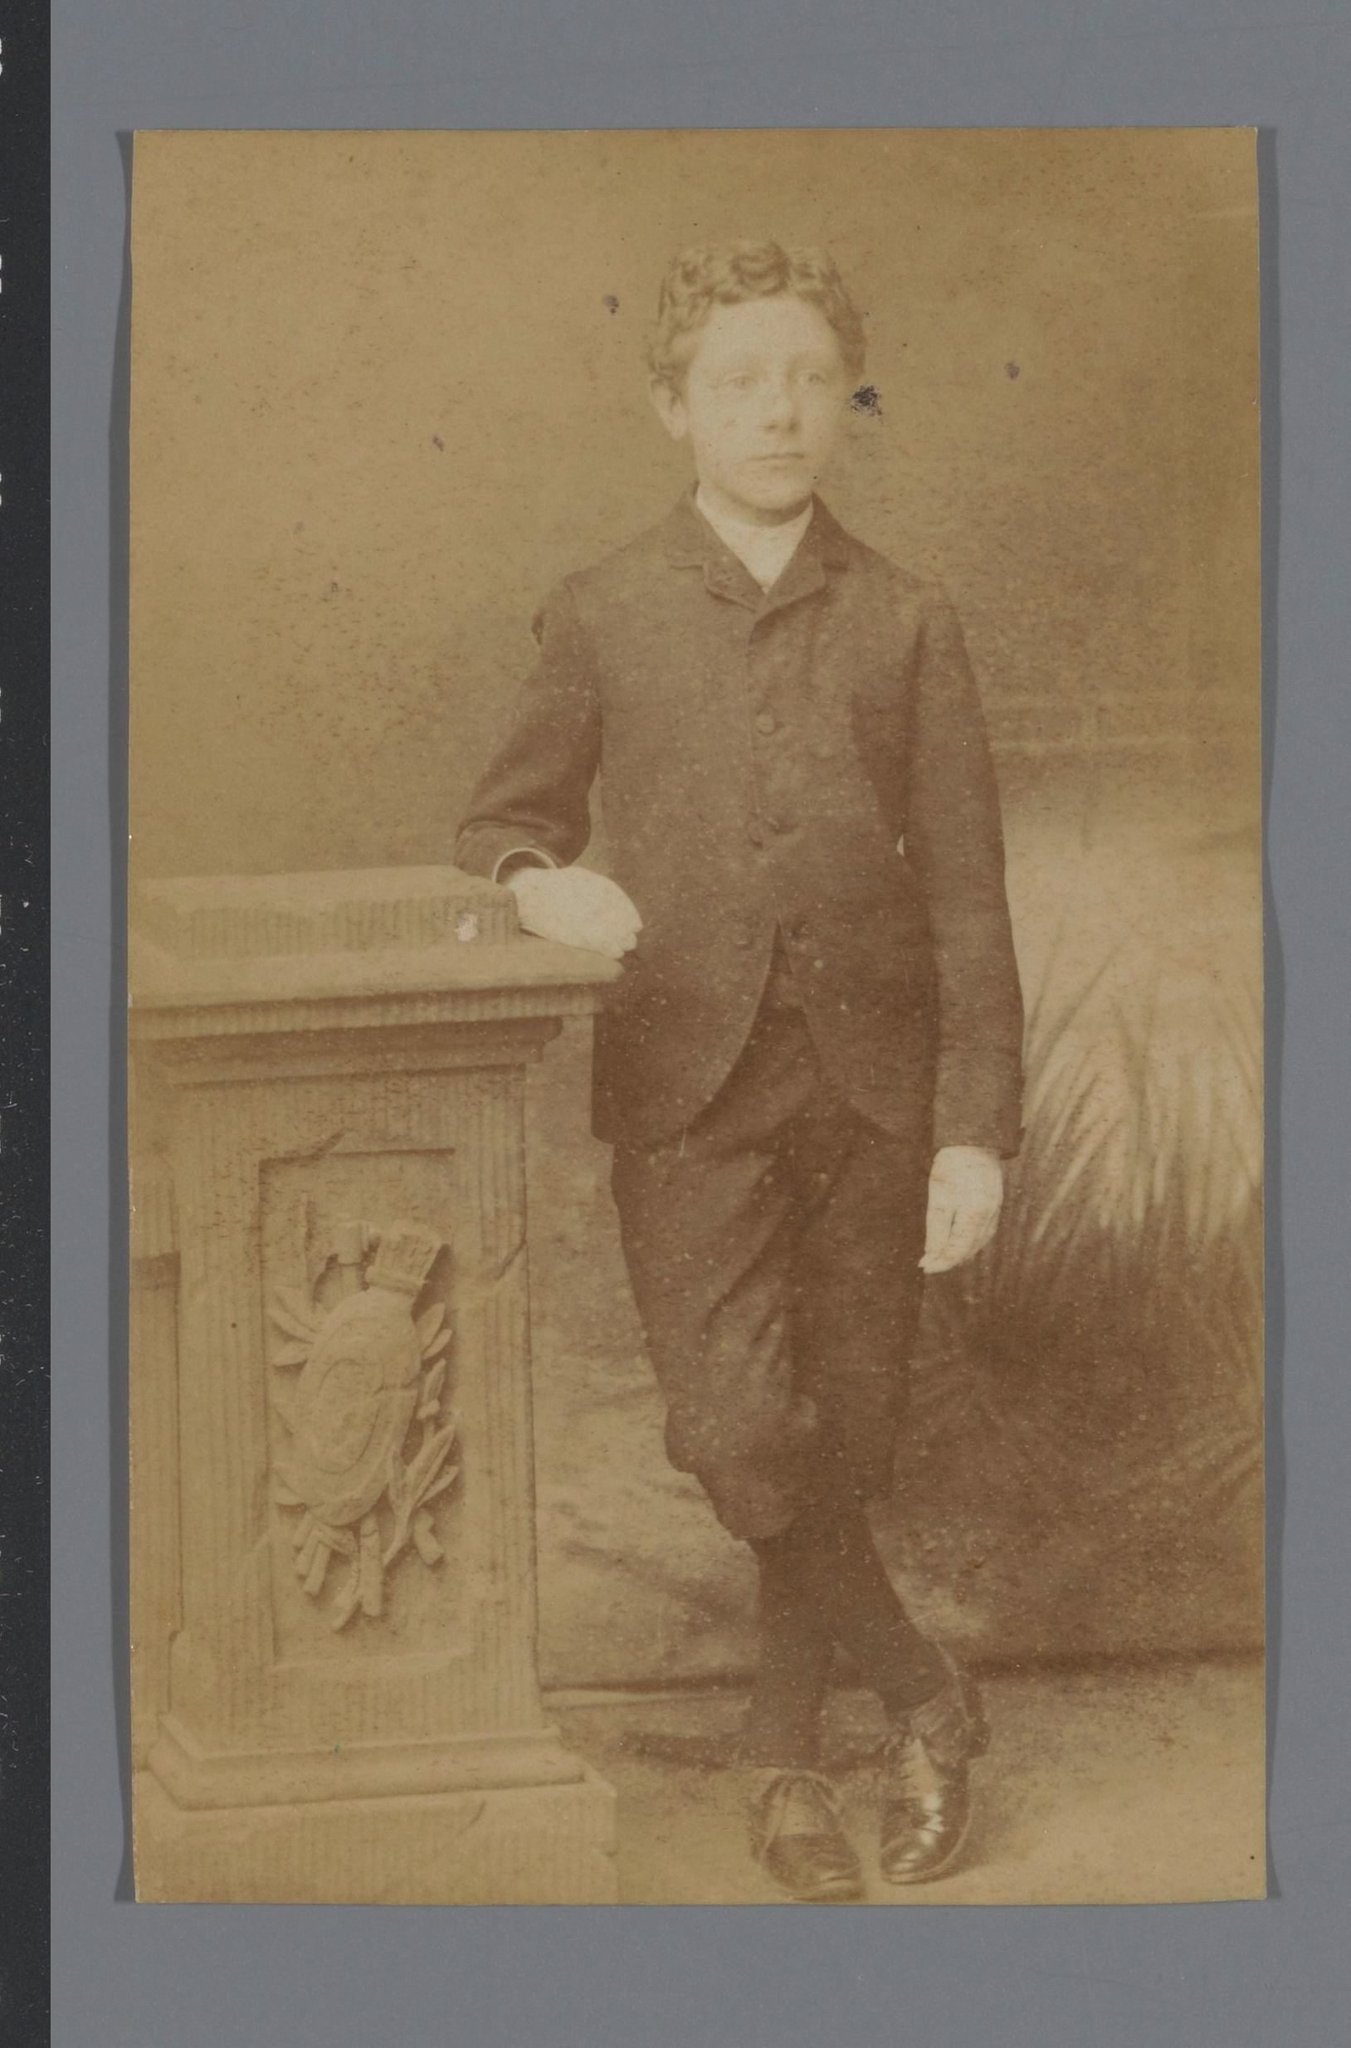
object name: photograph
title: Studioportret van een onbekende man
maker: Anonymous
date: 1875-1890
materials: photographic support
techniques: albumen print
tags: studio ~ photographer, adult man